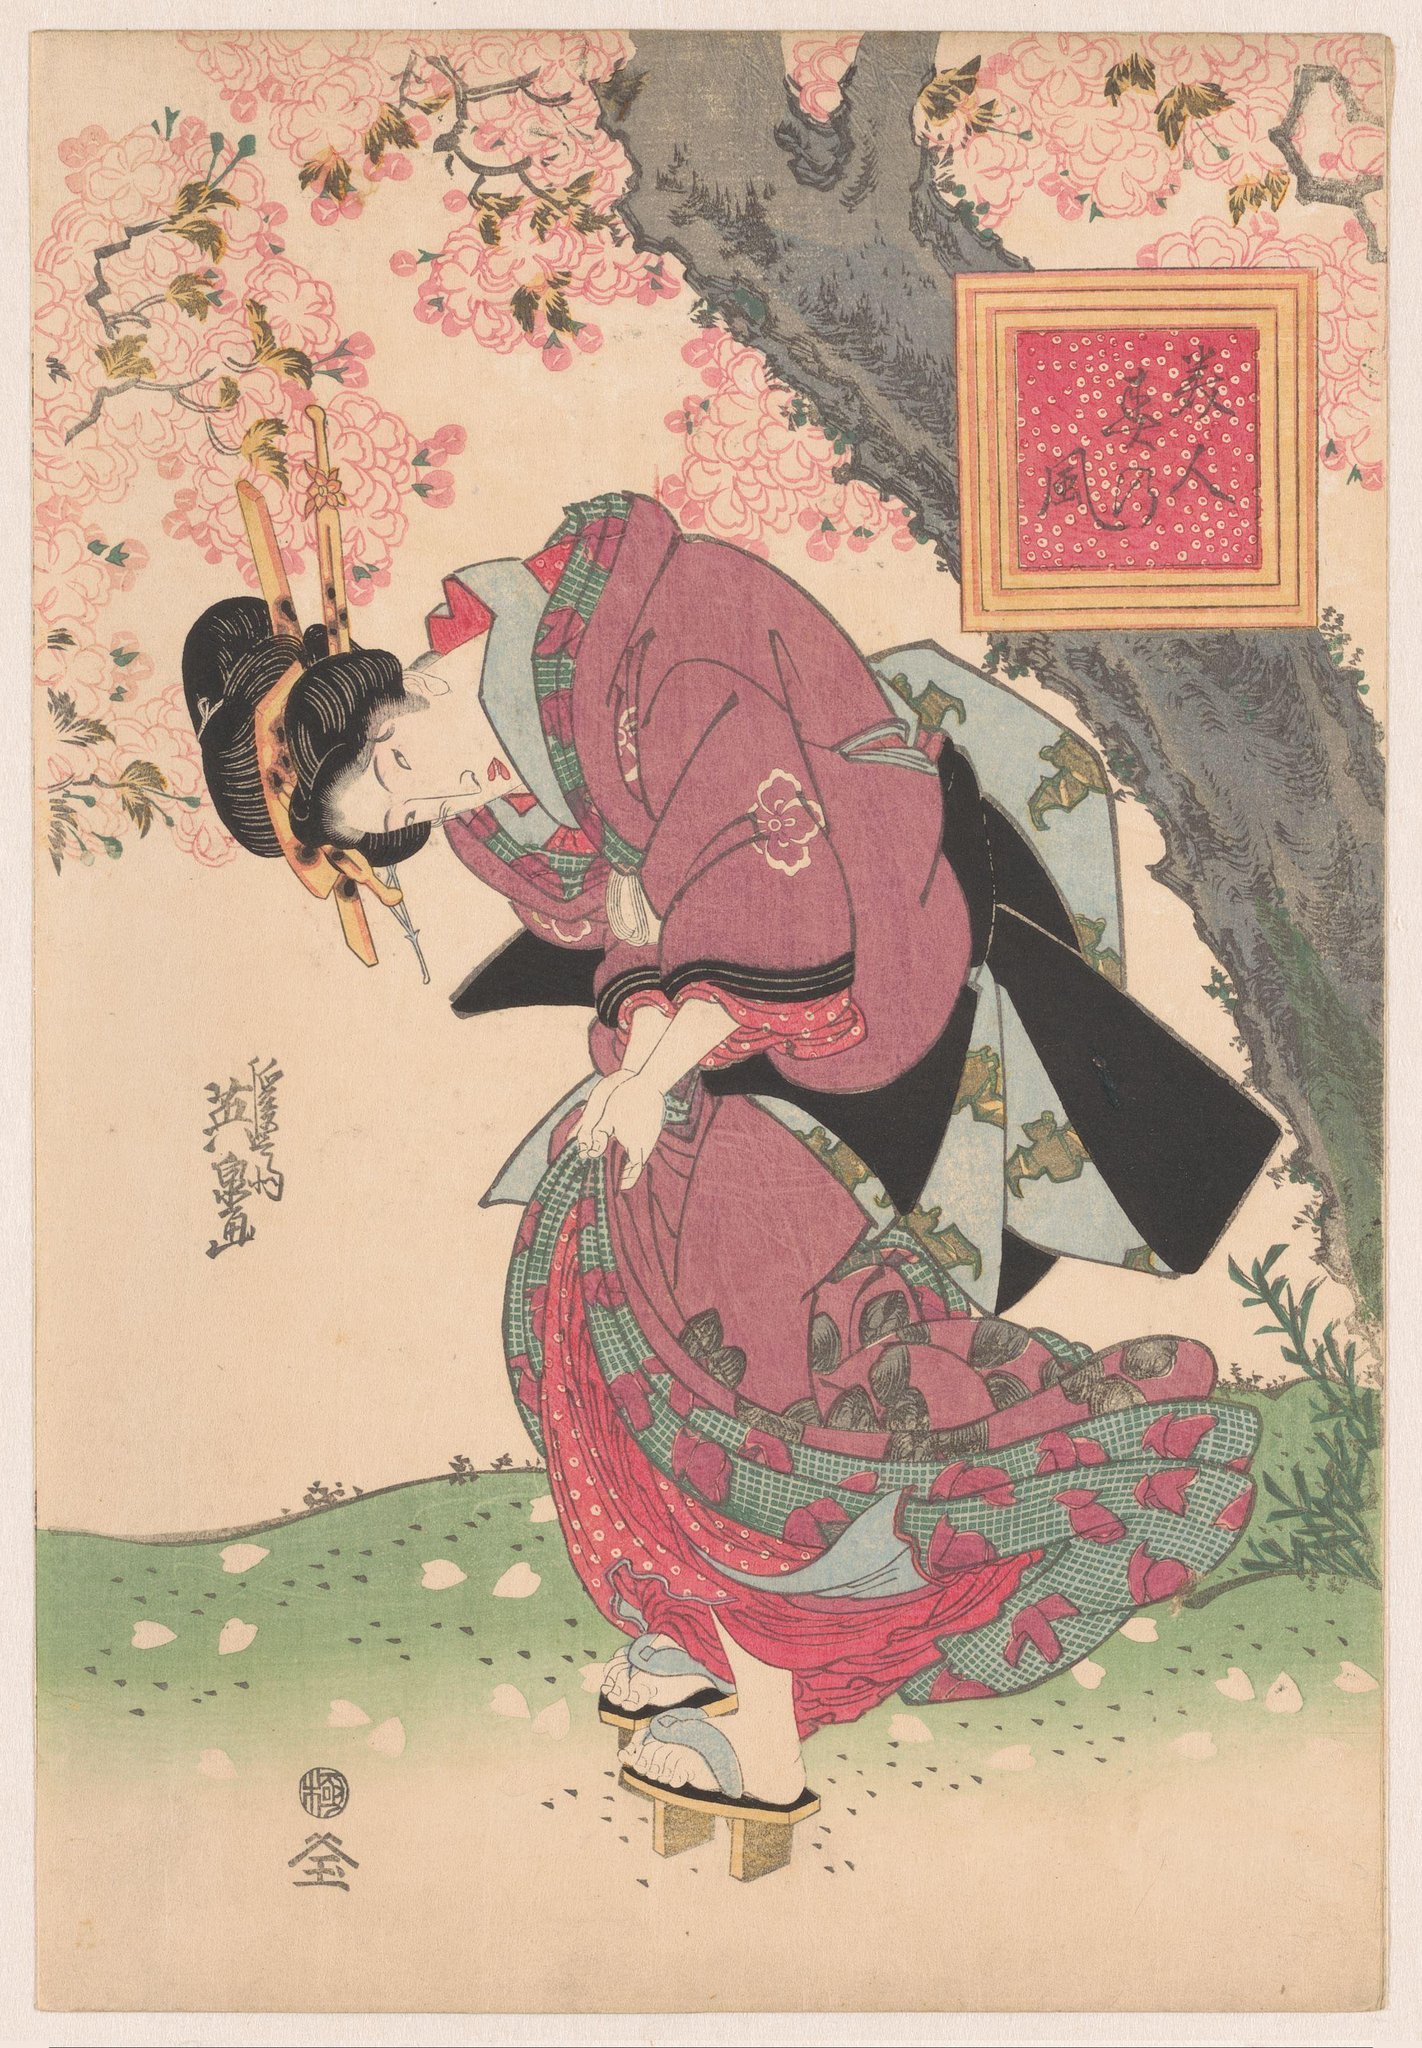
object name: print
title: Bijin haru no kaze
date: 1828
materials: paper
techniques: woodcut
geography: japan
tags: trees, adult woman, bending figure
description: Vrouw in kimono met vleermuis- en schelppatroon, voorovergebogen in de wind, bij een boom vol met roze kersenbloesem; op de grond afgewaaide blaadjes.